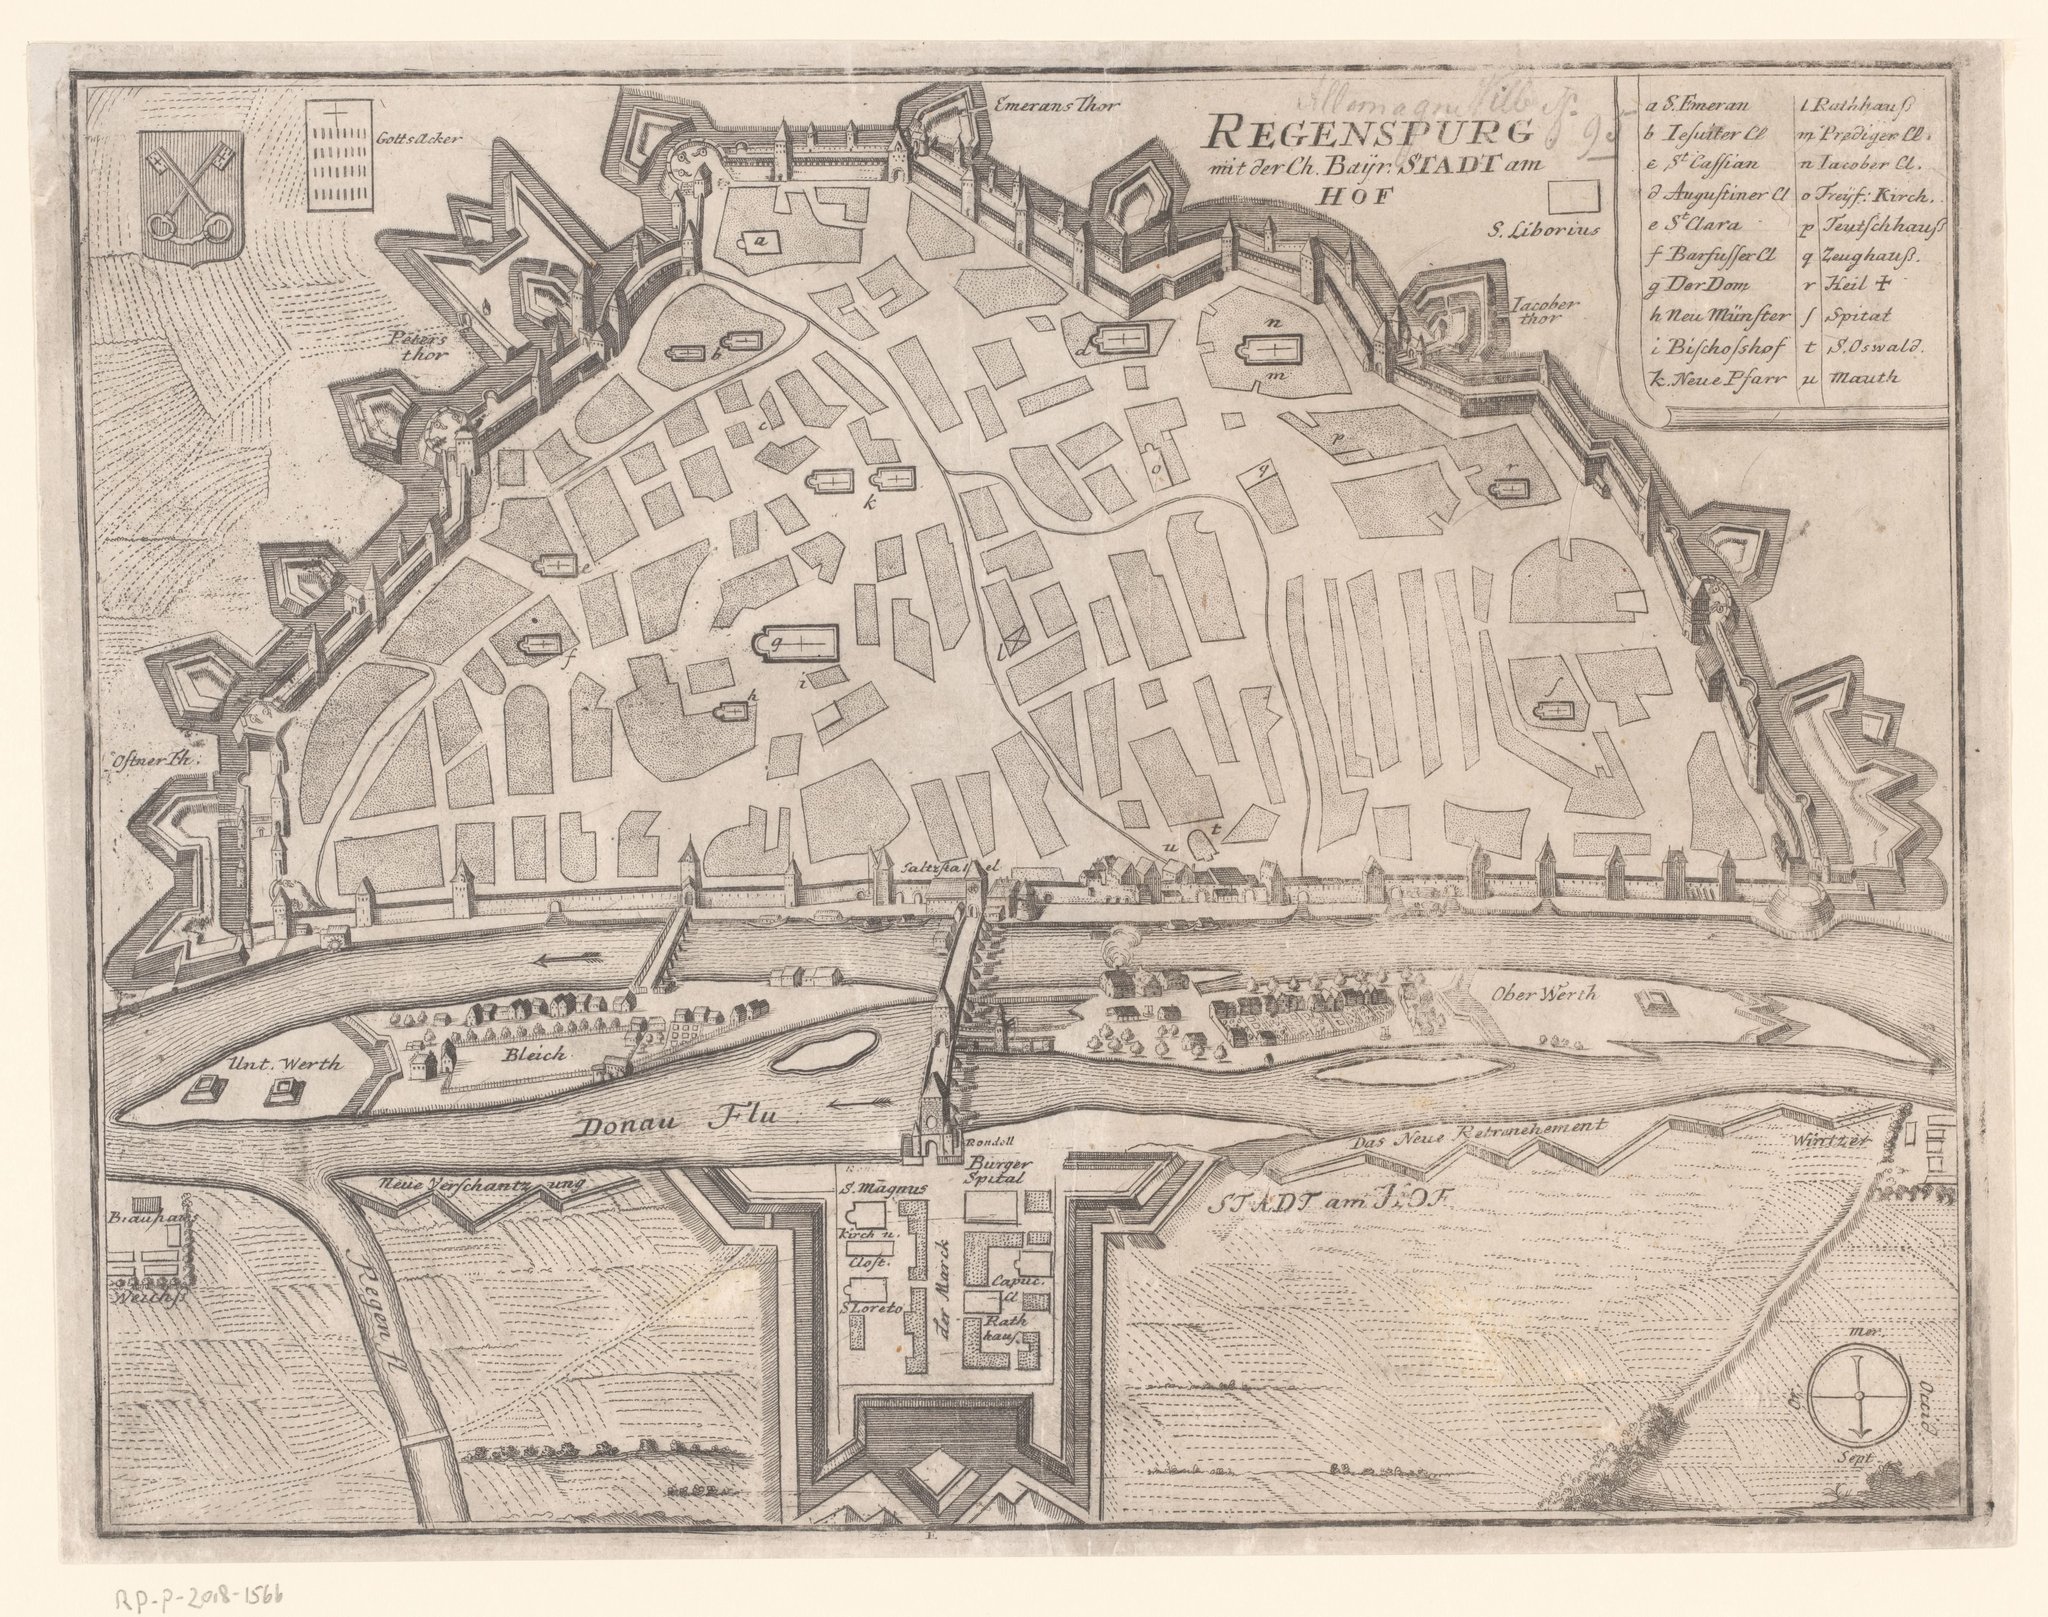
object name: print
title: Regenspurg mit der Ch. Baijr. Stadt am Hof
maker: Anonymous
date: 1650-1700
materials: paper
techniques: engraving, etching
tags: coat of arms (as symbol of the state, etc.) (+ city; municipal), maps of cities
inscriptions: collector's mark: Lugt 2228